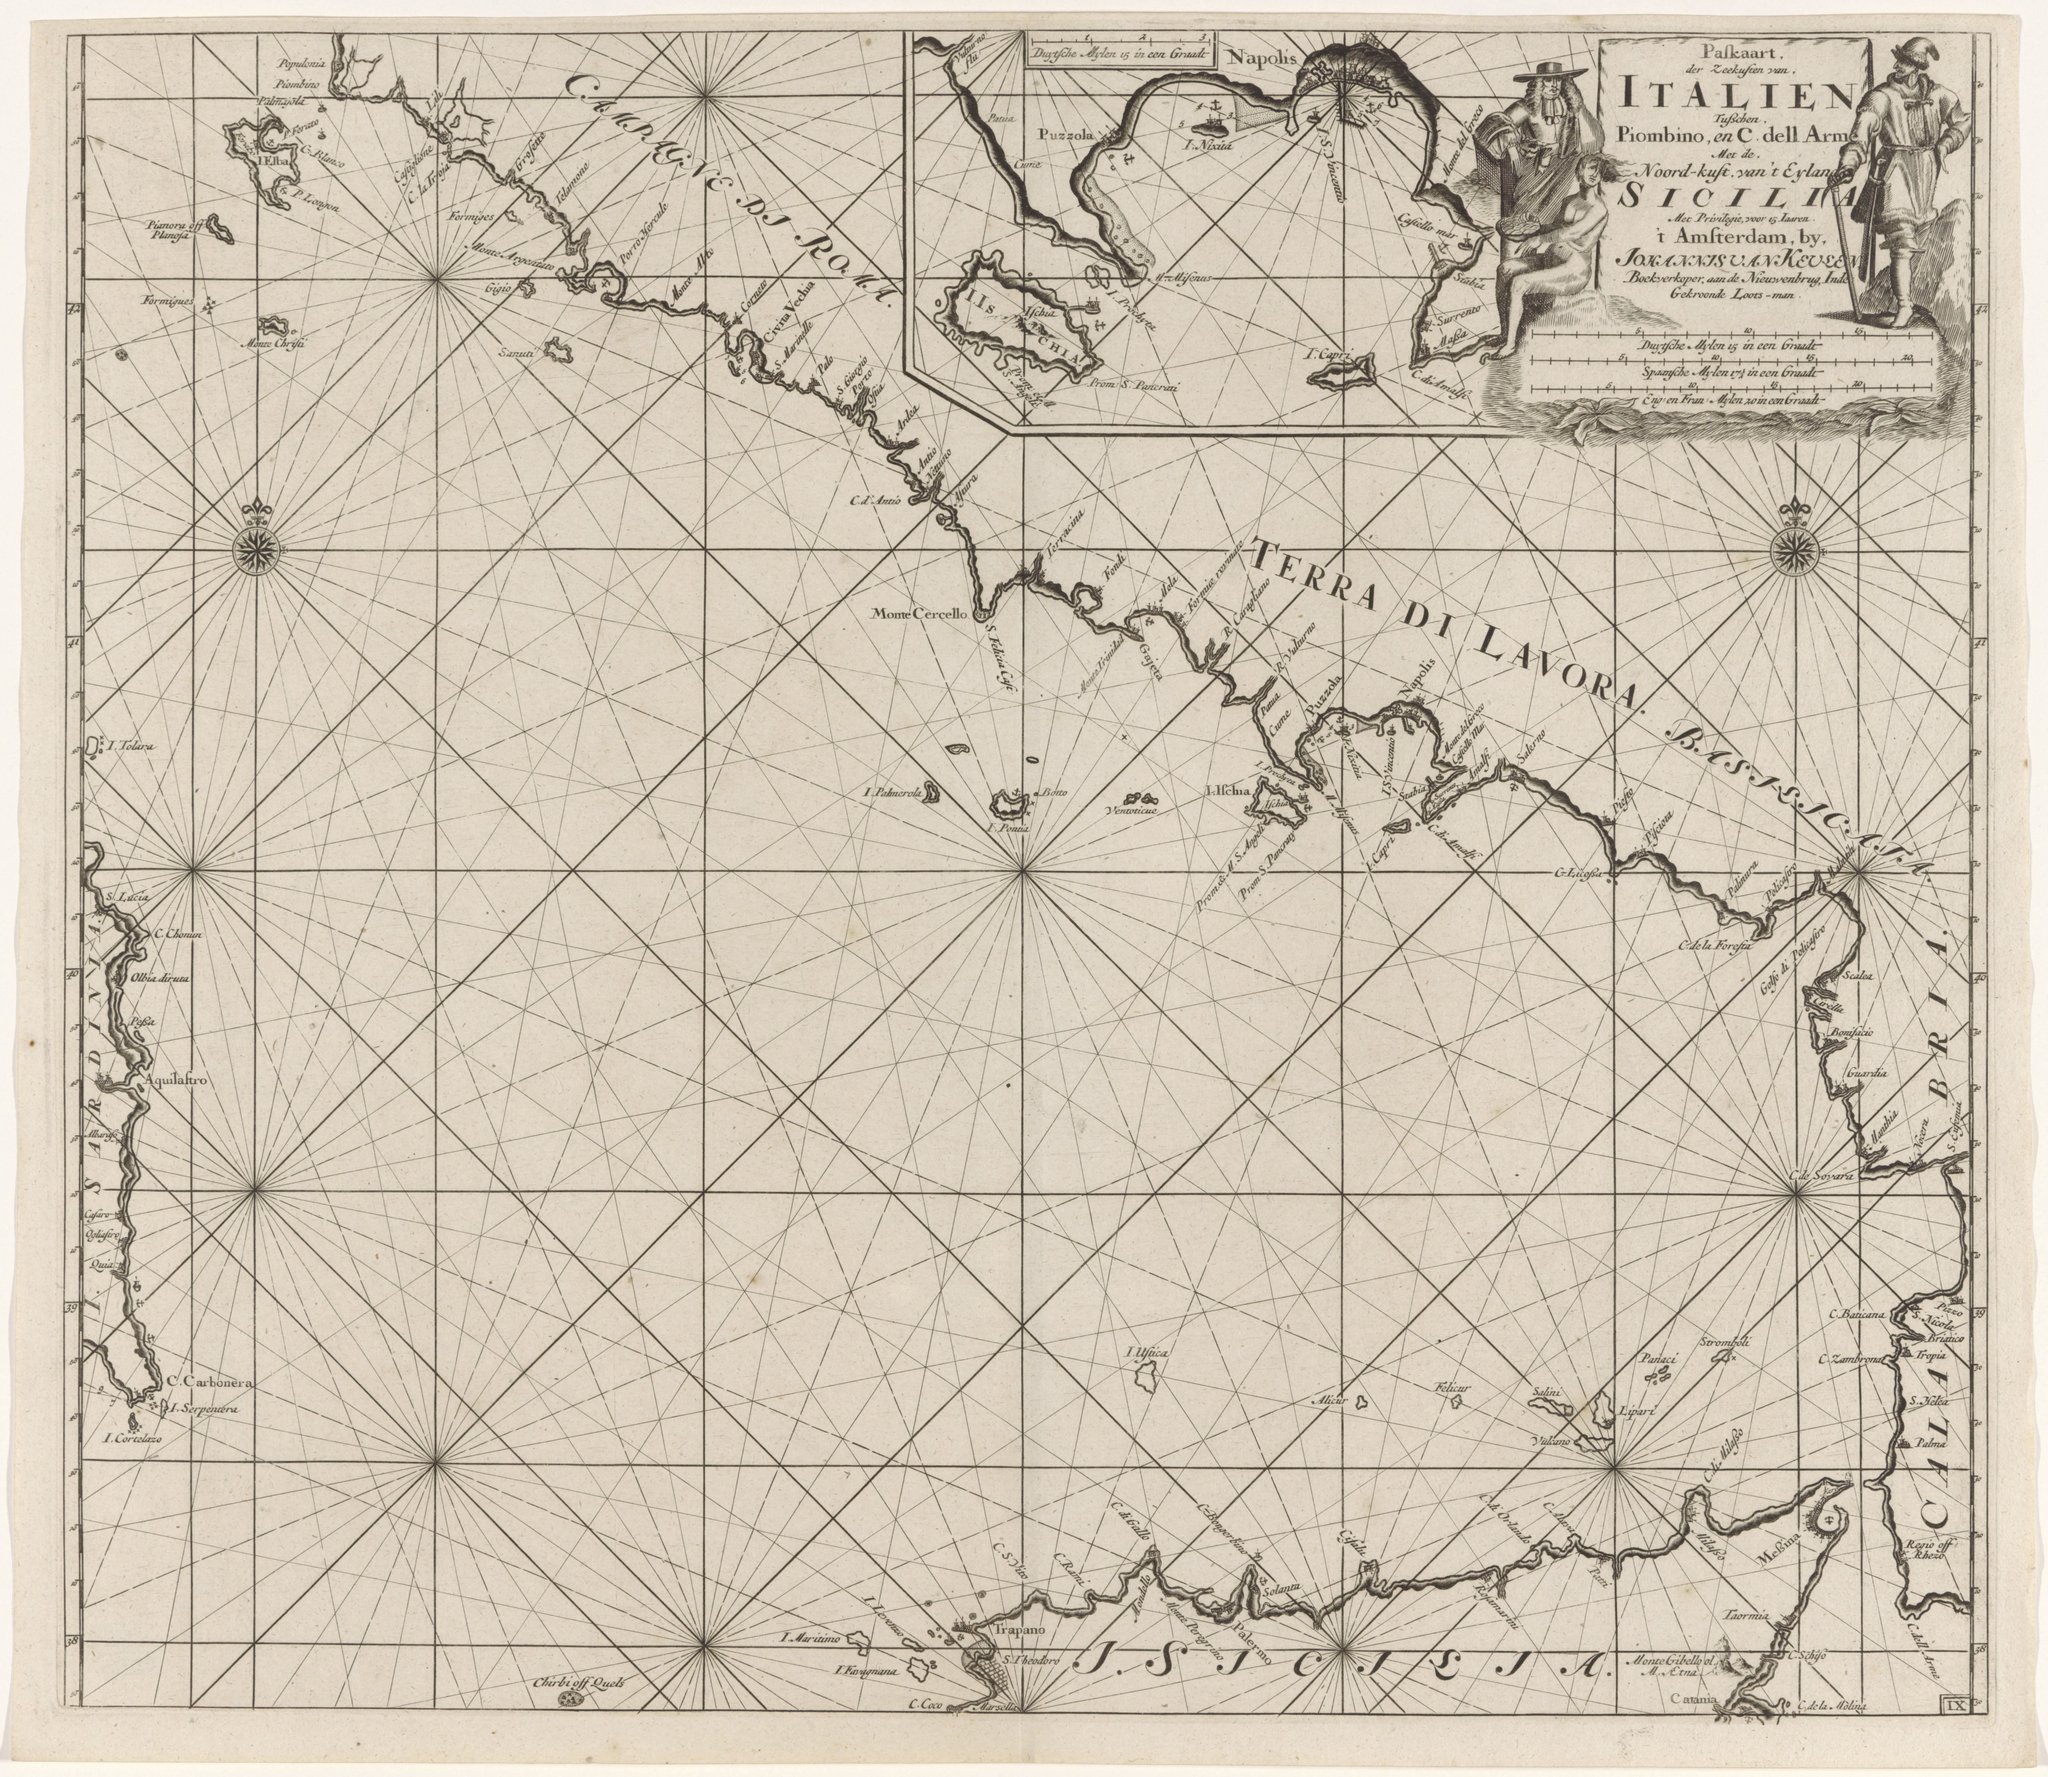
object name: print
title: Paskaart, der zeekusten van, Italien tusschen, Piombino, en C. dell Arme met de, noord-kust, van ‘t eyland Sicilia.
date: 1682-1803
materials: paper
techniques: engraving, etching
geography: amsterdam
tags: head-gear: hat (+ men's clothes), tools, aids, implements ~ crafts and industries: axe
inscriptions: collector's mark: Lugt 2228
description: Paskaart van een deel van de zuidwestkust van Italië en de noordkust van Sicilië, met een inzetkaart van de Golf van Napels, met twee kompasrozen, het Noorden ligt boven. Rechtsboven de titel, het adres van de uitgever en de schaalverdeling, weergegeven in Duitse, Spaanse en Engelse of Franse mijlen (schaal: c. 1:1.100.000). Deze gegevens worden geflankeerd door twee heren en een naakte dame.